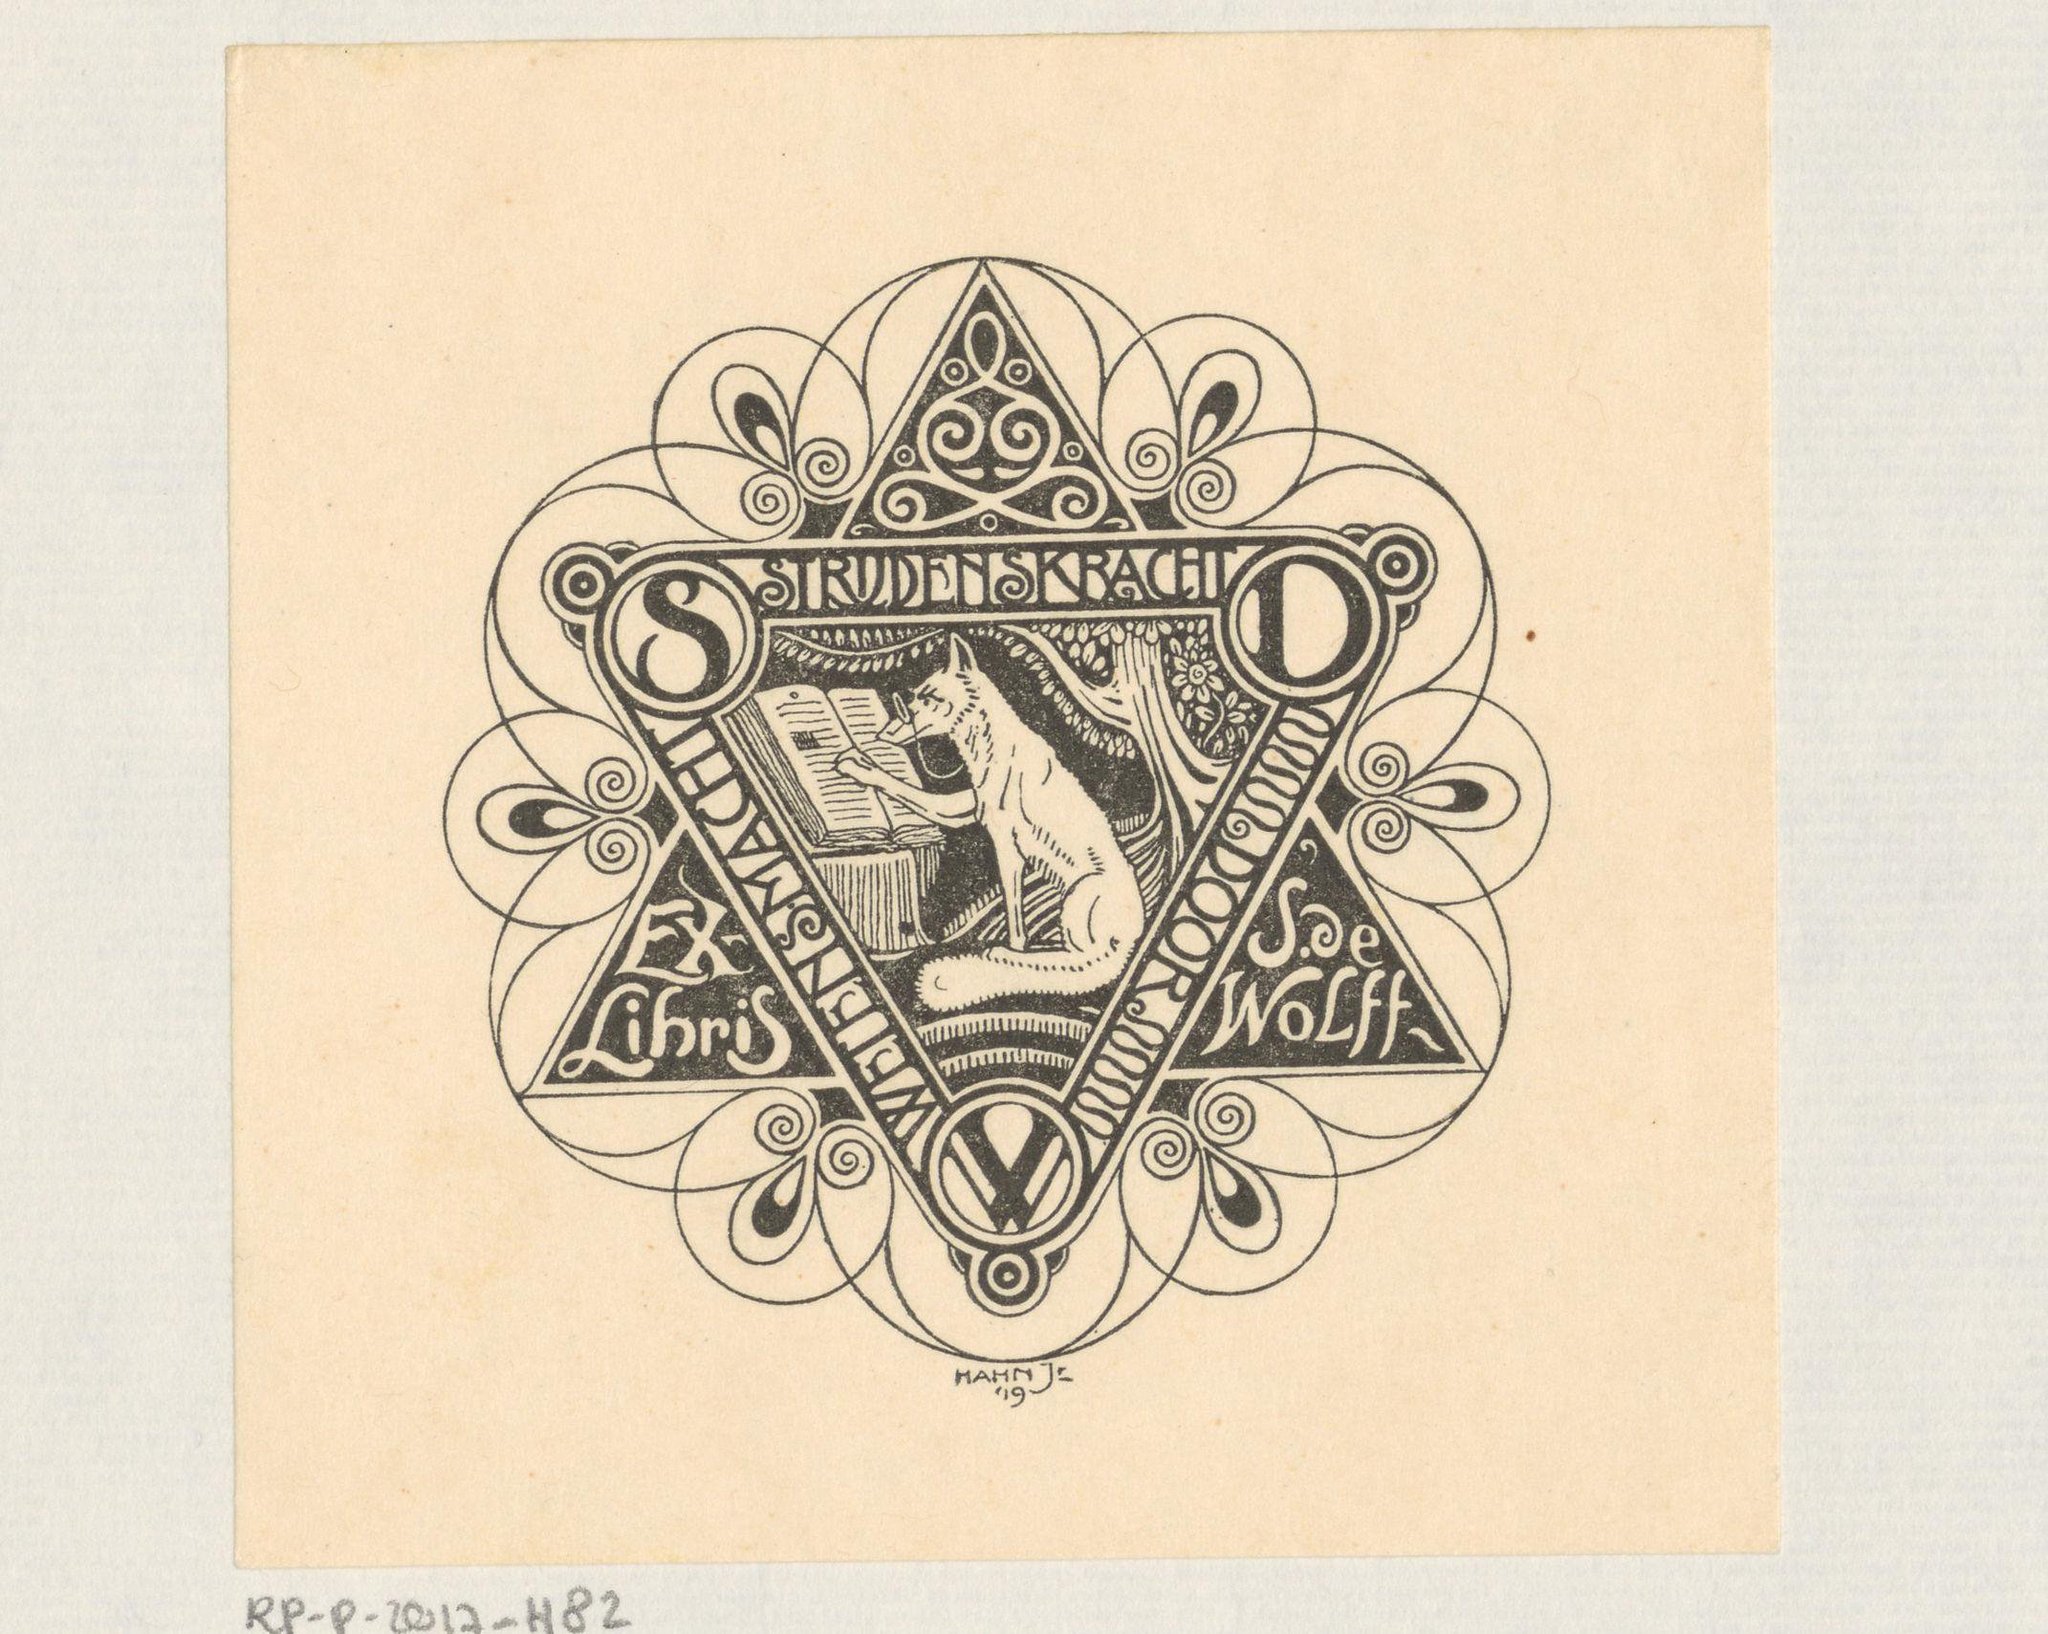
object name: bookplate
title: Ex libris van S. de Wolff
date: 1919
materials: paper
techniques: printing block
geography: netherlands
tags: amsterdam, reading, beasts of prey, predatory animals: wolf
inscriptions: inscription: ‘door Hahn jr.’